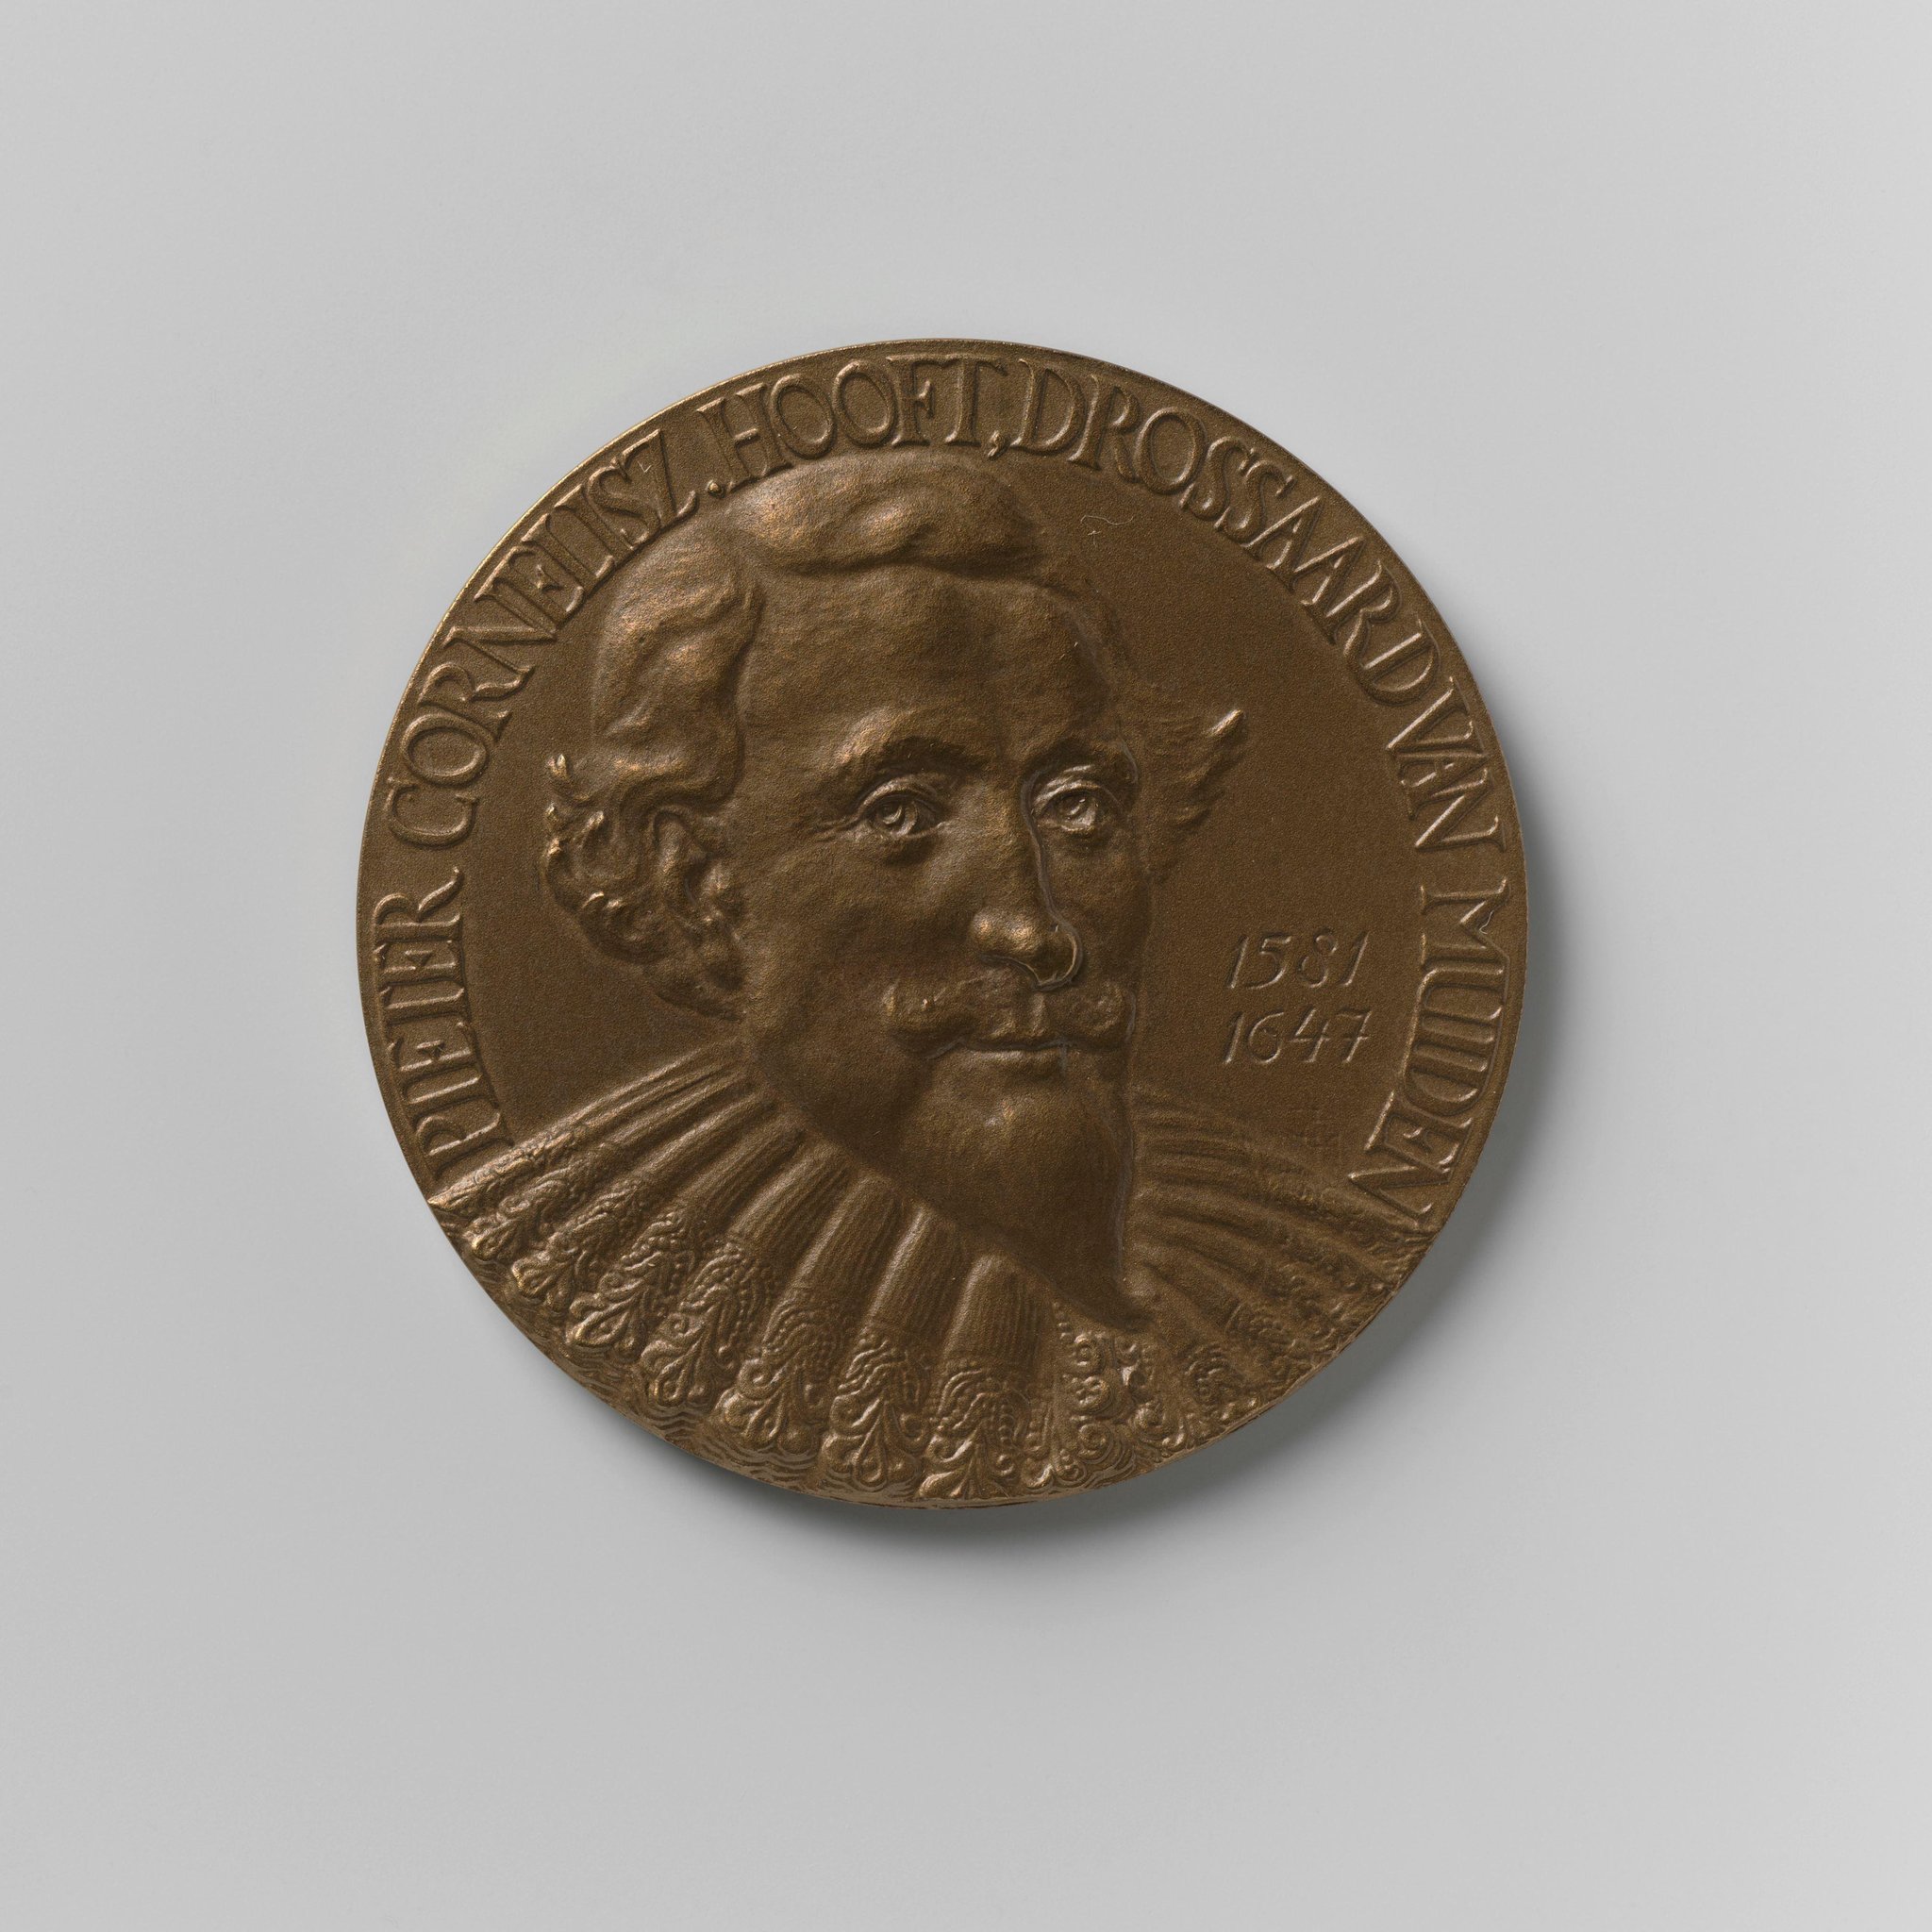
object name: history medal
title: Driehonderdjarige herdenking van het overlijden van Pieter Corneliszoon Hooft 1947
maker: joop hekman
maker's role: sculptor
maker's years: 1921-2013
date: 1947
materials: bronze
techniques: striking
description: Bronzen penning, op de voorzijde het borstbeeld van Hooft half naar rechts met omschrift en in het veld twee jaartallen, op de keerzijde het Muiderslot met boven een tekstlint en onder drie regels tekst, met verklaring.